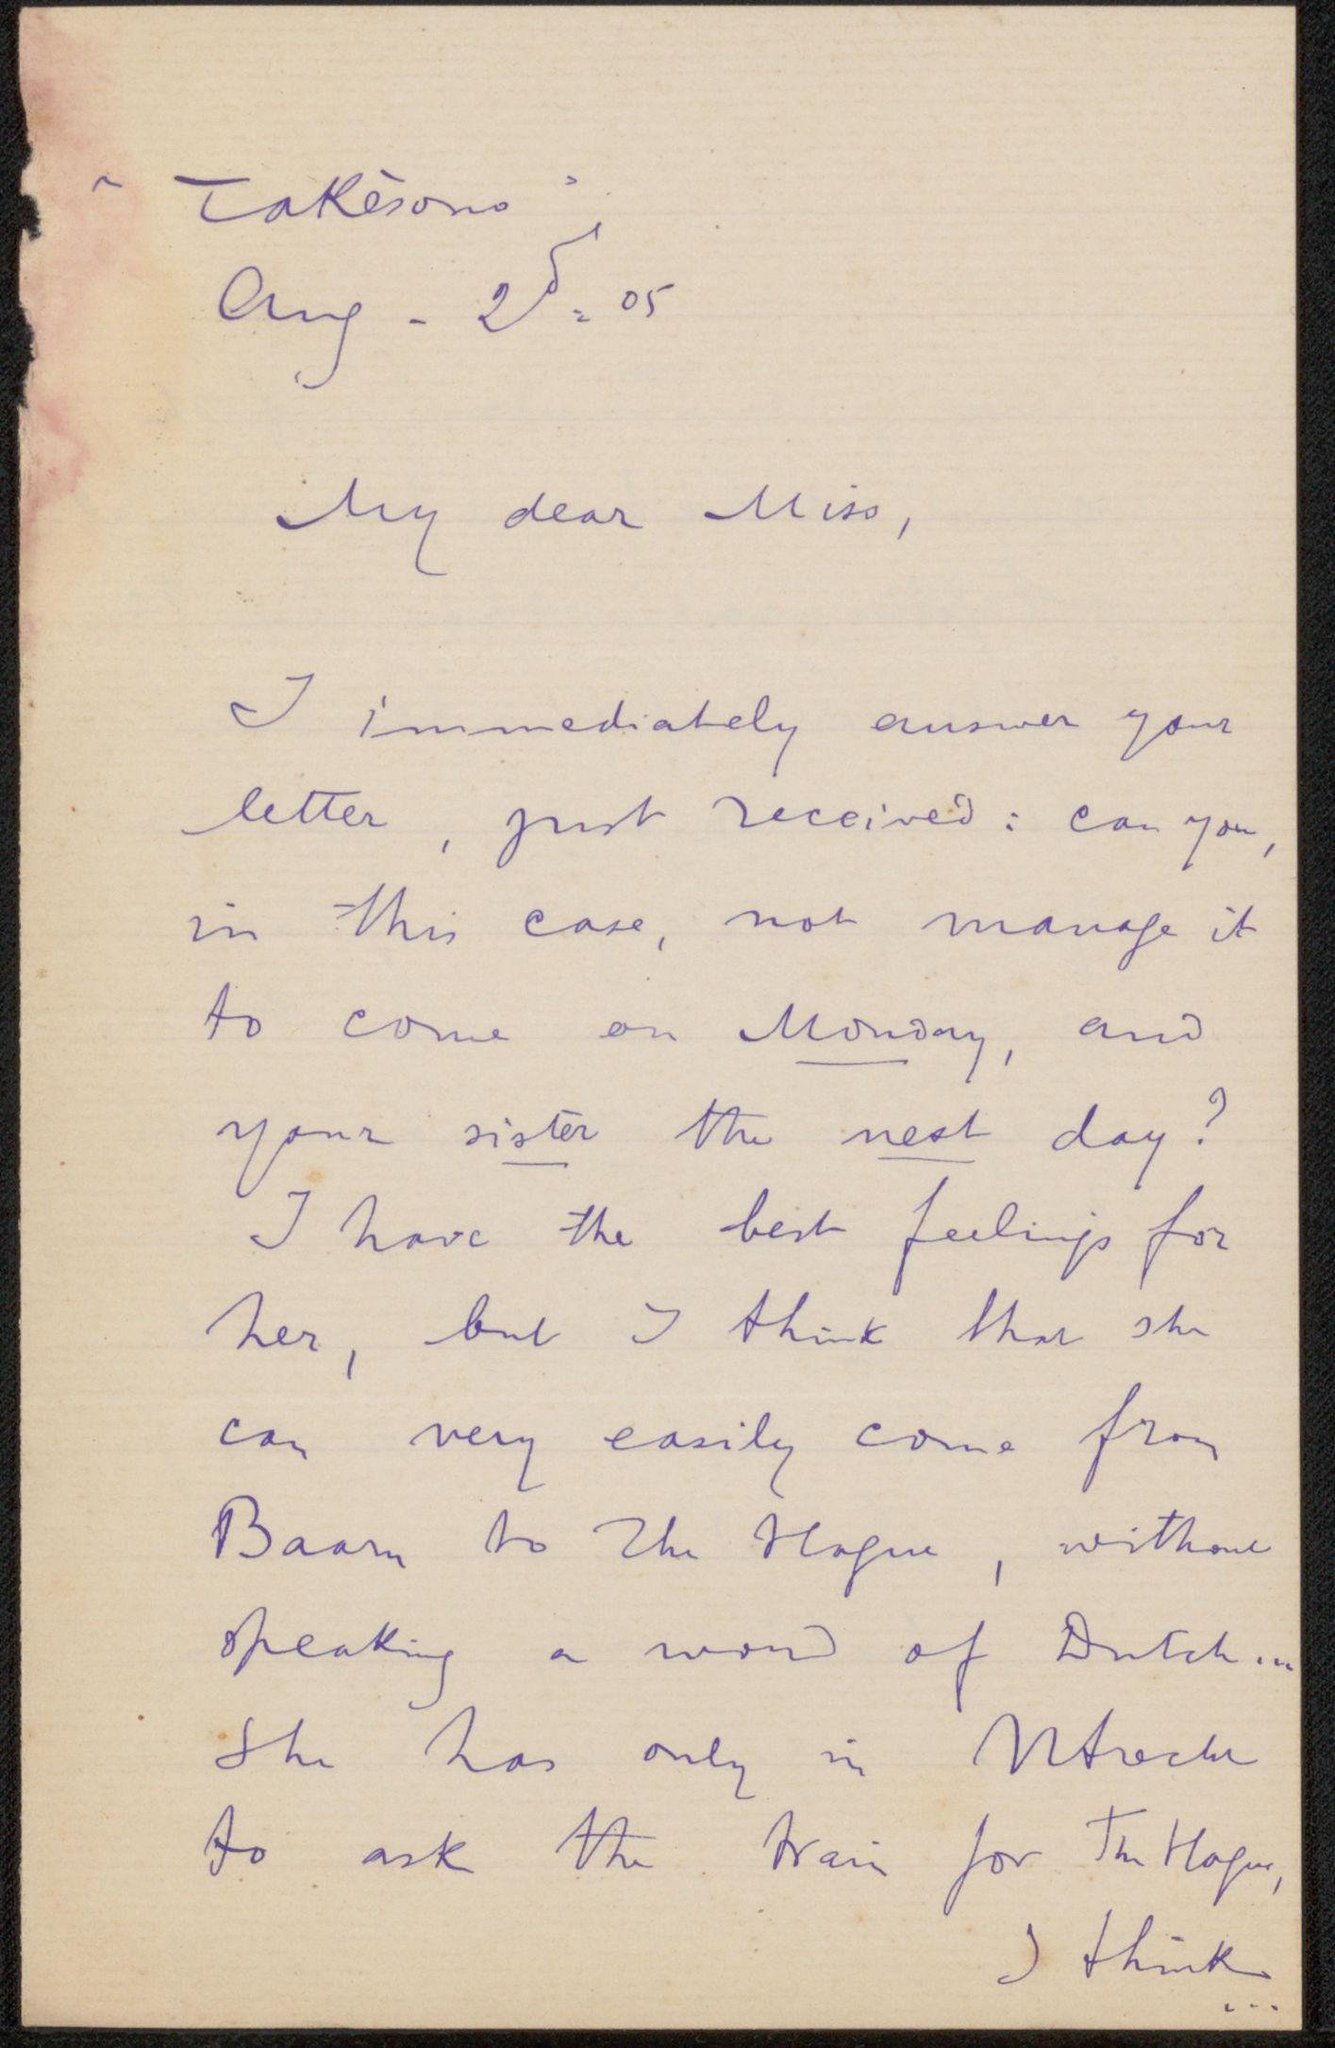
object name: letter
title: Brief aan Elsie Maud Cownie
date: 1905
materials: ink, pencil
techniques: pen, writing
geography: the hague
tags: elsie maud cownie, workshop, studio of the artist (in general), the hague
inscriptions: watermark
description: Verso brief bevat aantekening van een anonieme schrijver.